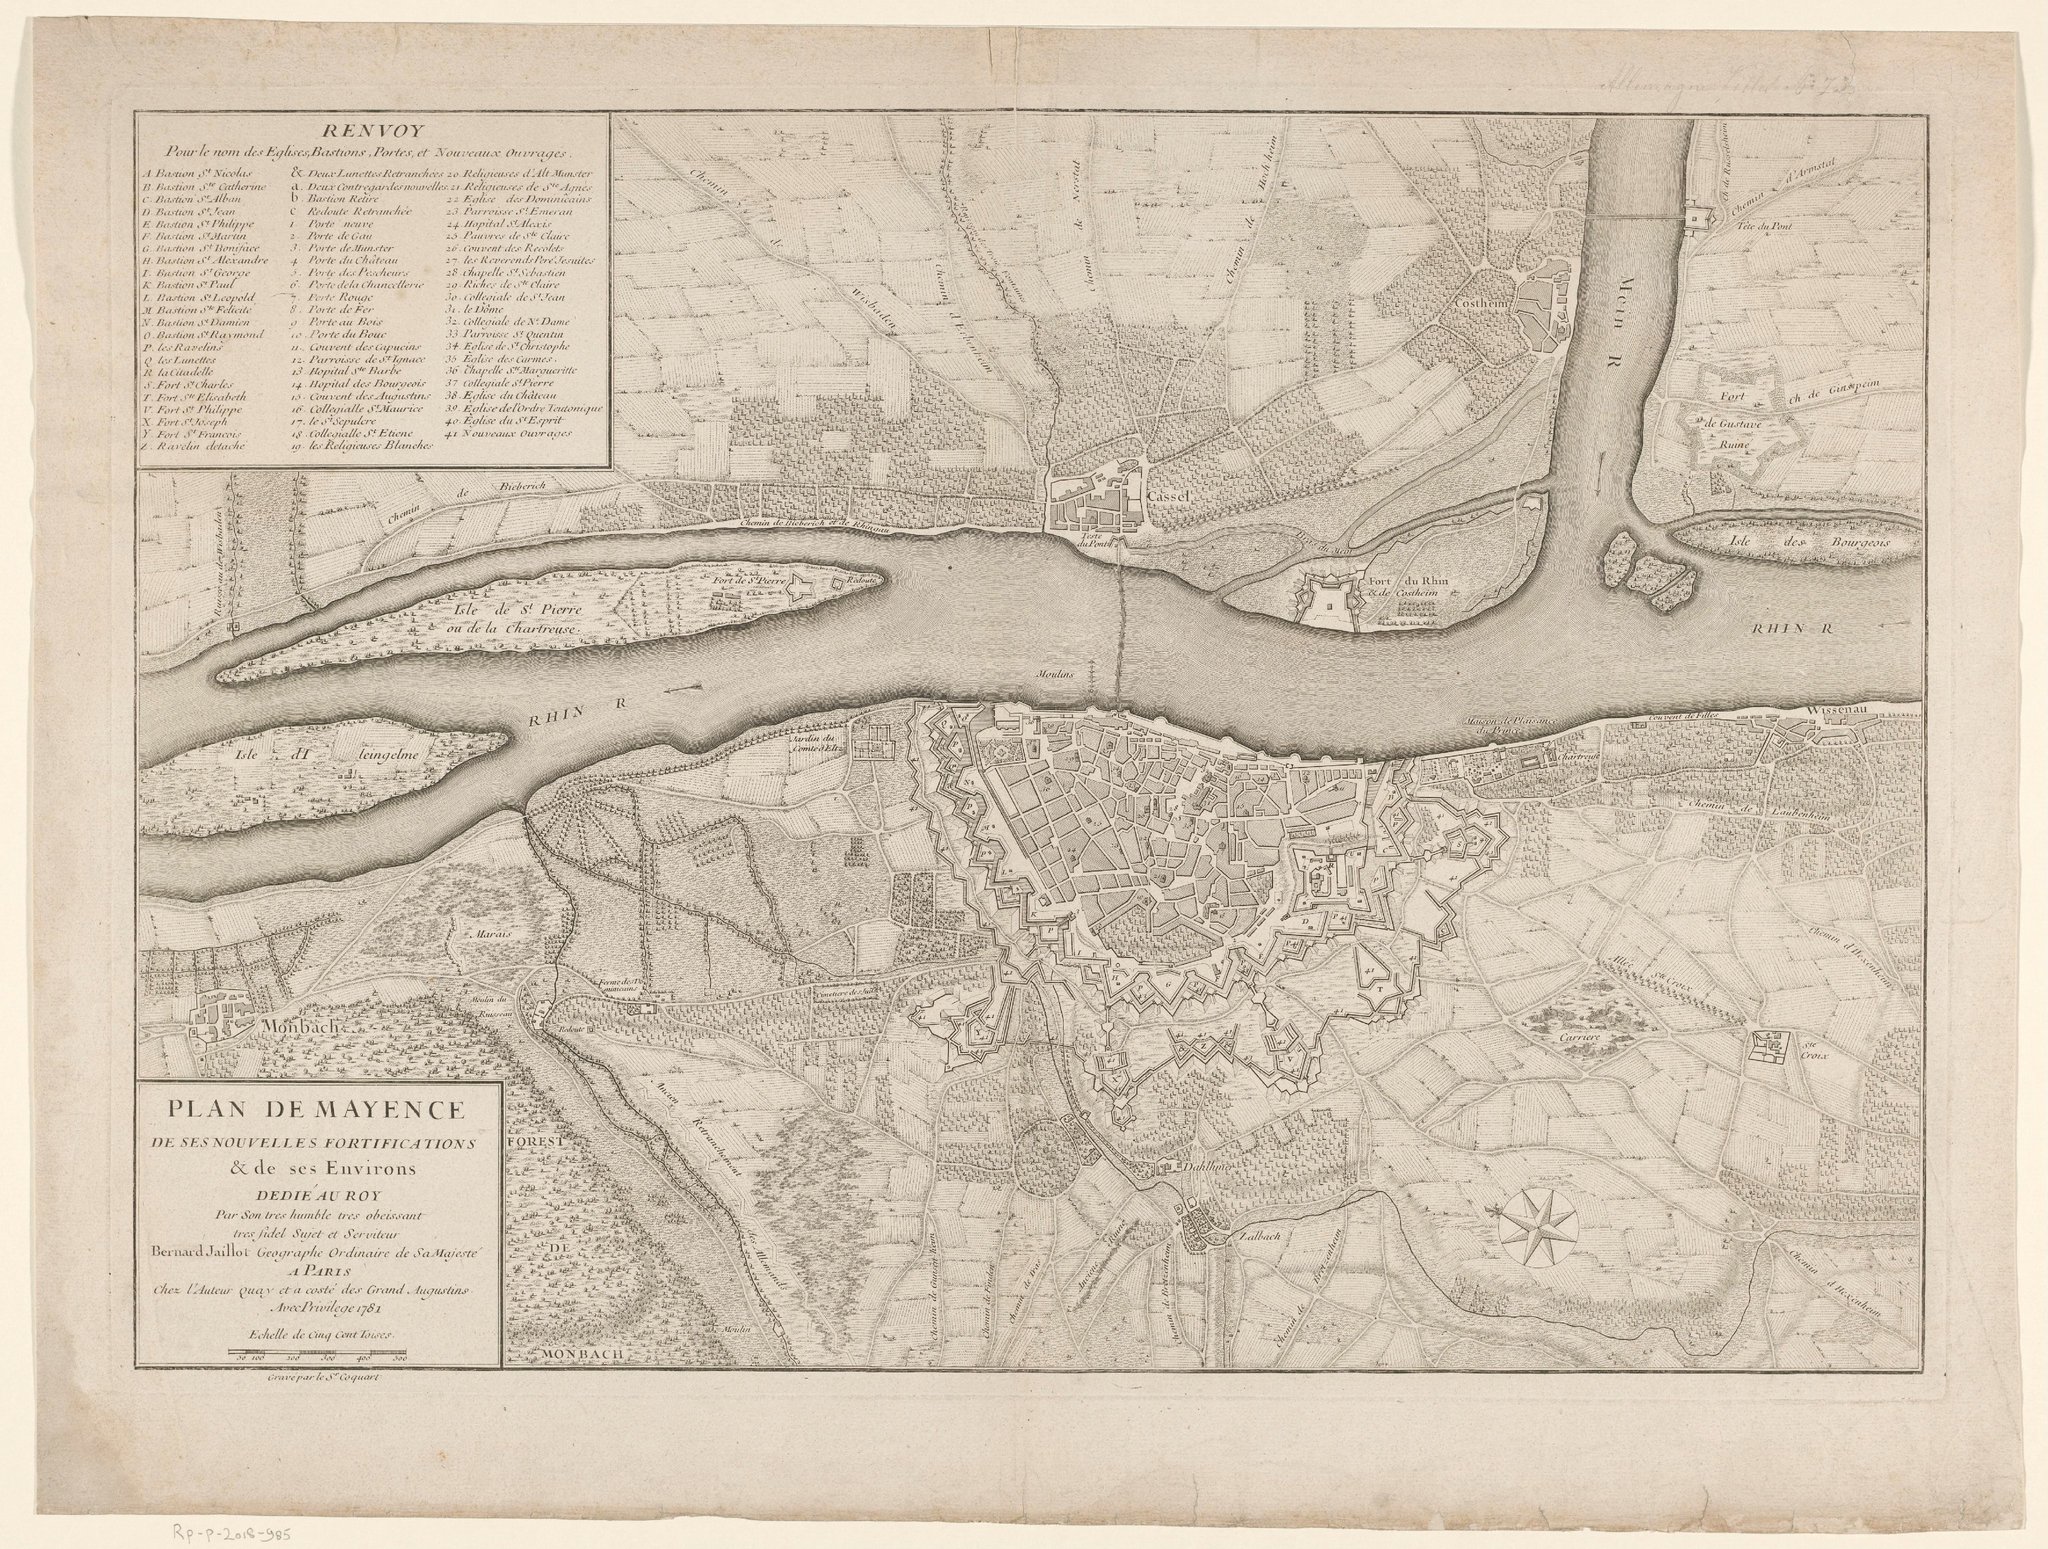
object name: area plan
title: Plattegrond van Mainz en zijn omgeving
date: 1781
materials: paper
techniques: engraving, etching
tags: maps of cities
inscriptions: collector's mark: Lugt 2228